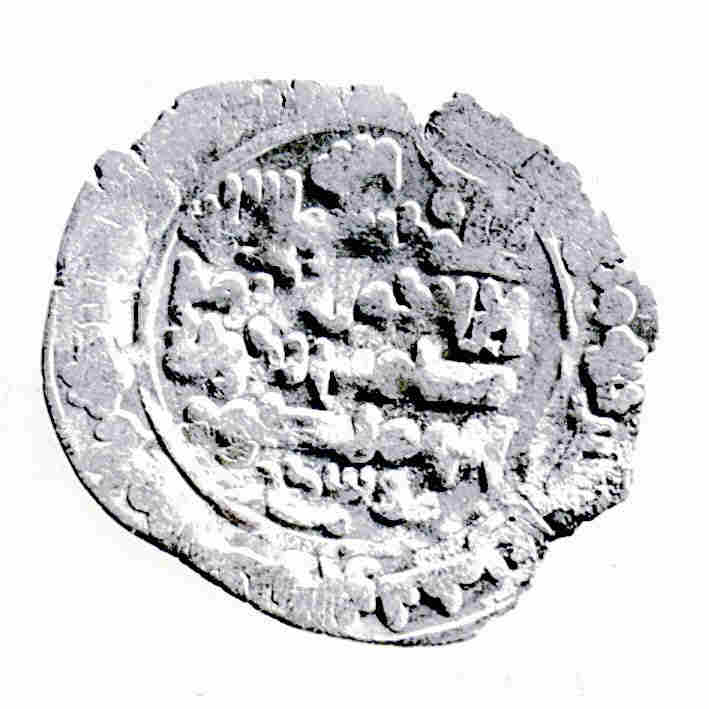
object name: coin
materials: silver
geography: iran